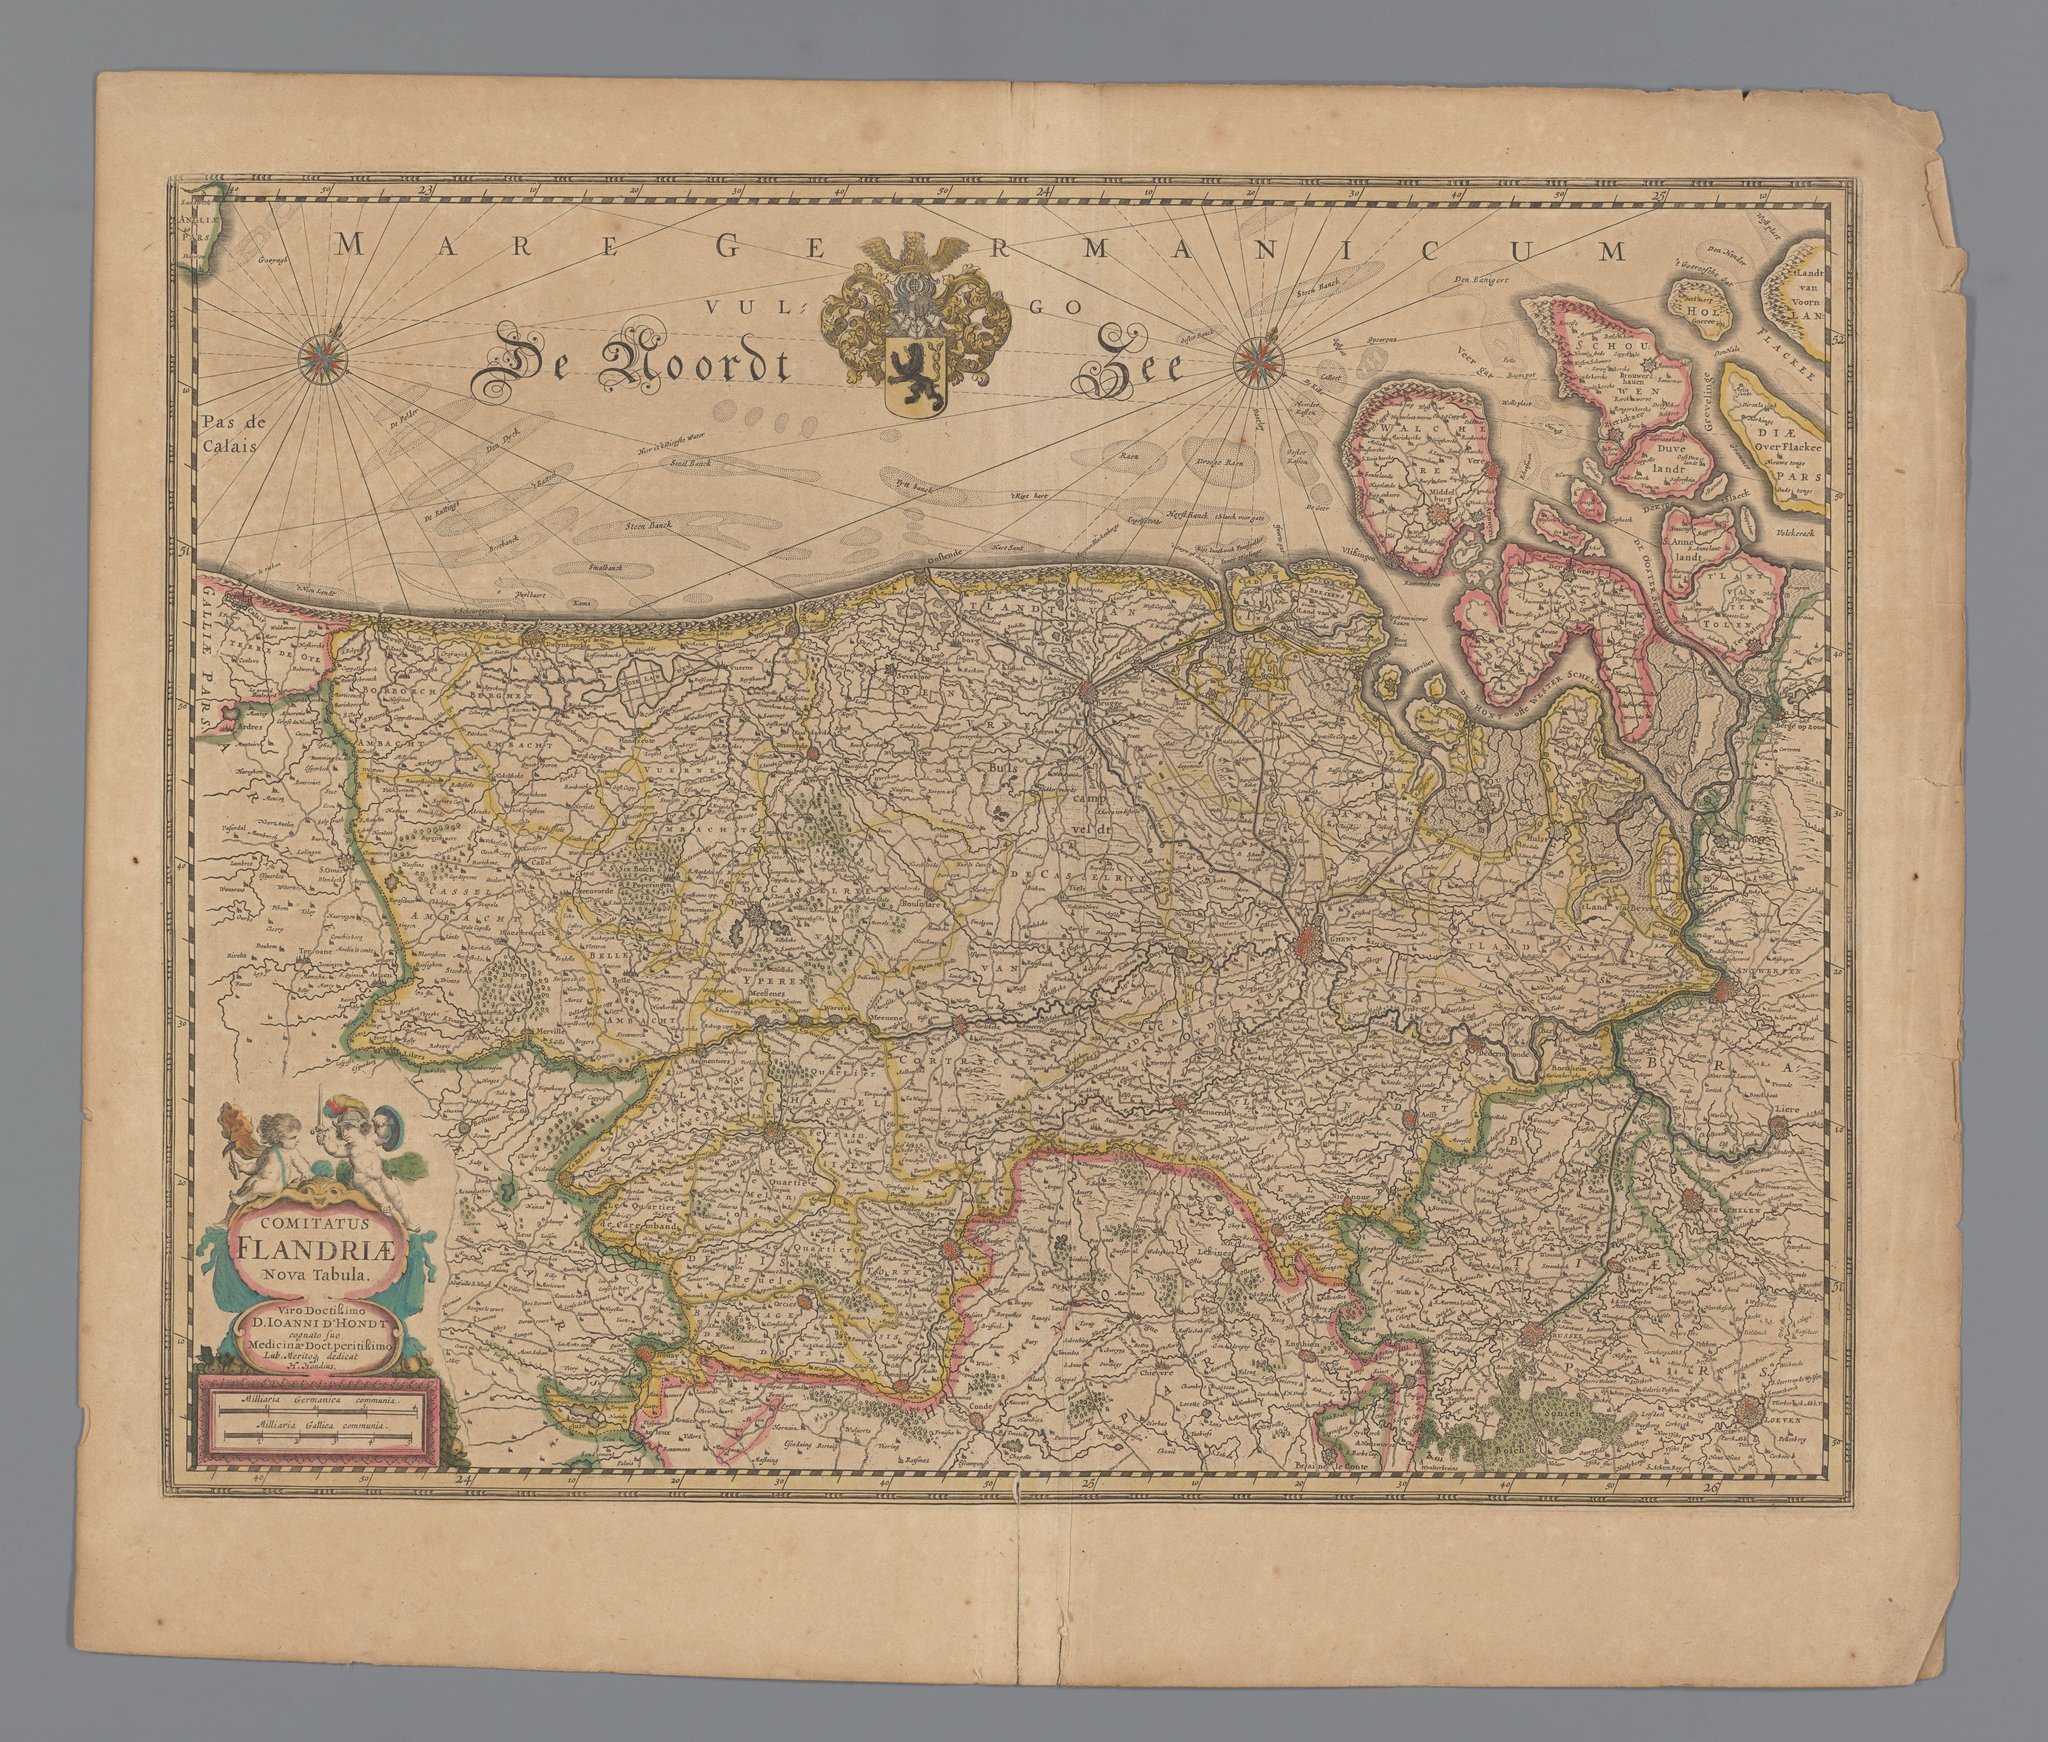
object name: book illustration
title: Comitatus Flandriae nova Tabula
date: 1638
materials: paper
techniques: engraving, etching, hand coloring, letterpress printing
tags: maps of separate countries or regions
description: Prent gebruikt in: Mercator, Gerard, en Jodocus Hondius. Atlas Novus sive descriptio Geographica totius Orbis Terrarum, Tabulis Aeneis Luculentissimis & Accuratissimis Exornata, Tribus Tomis Distinctus. Amsterdam: Henricus Hondius, 1638. Of: Mercator, Gerard, en Jodocus Hondius. Atlas Novus sive descriptio Geographica totius Orbis Terrarum, Tabulis Aeneis Luculentissimis & Accuratissimis Exornata, Tribus Tomis Distinctus. Amsterdam: Johannes Janssonius, 1638.